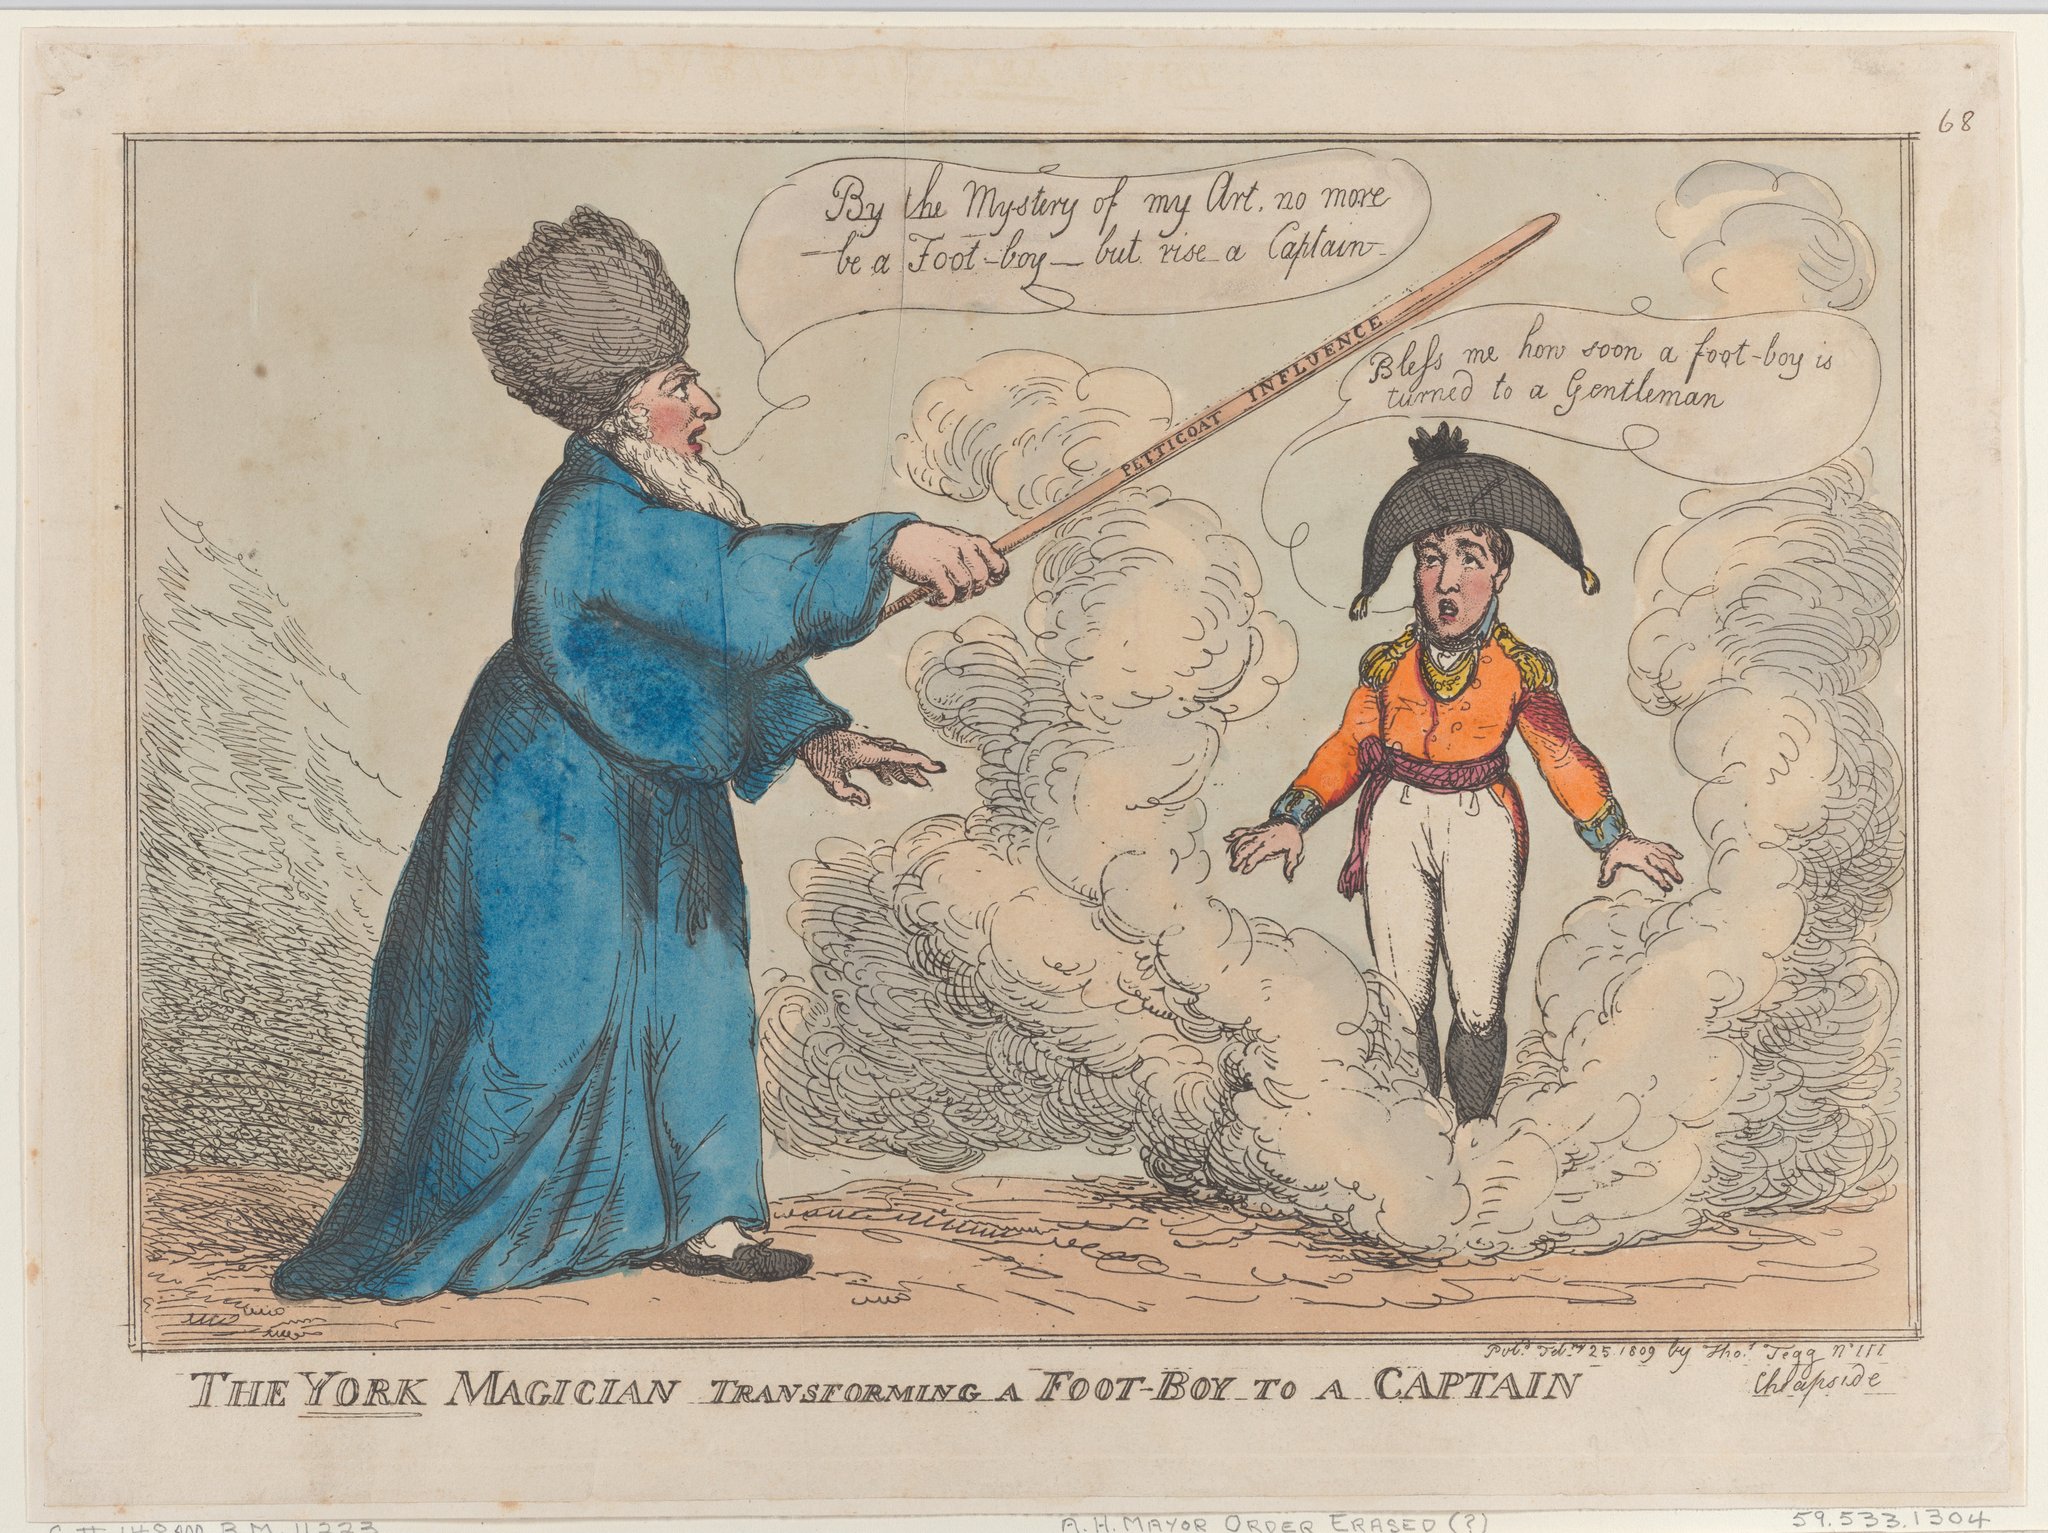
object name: print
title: The York Magician Transforming a Foot-Boy to a Captain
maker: thomas rowlandson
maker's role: artist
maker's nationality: british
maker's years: 1757-1827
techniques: etching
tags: satire,men